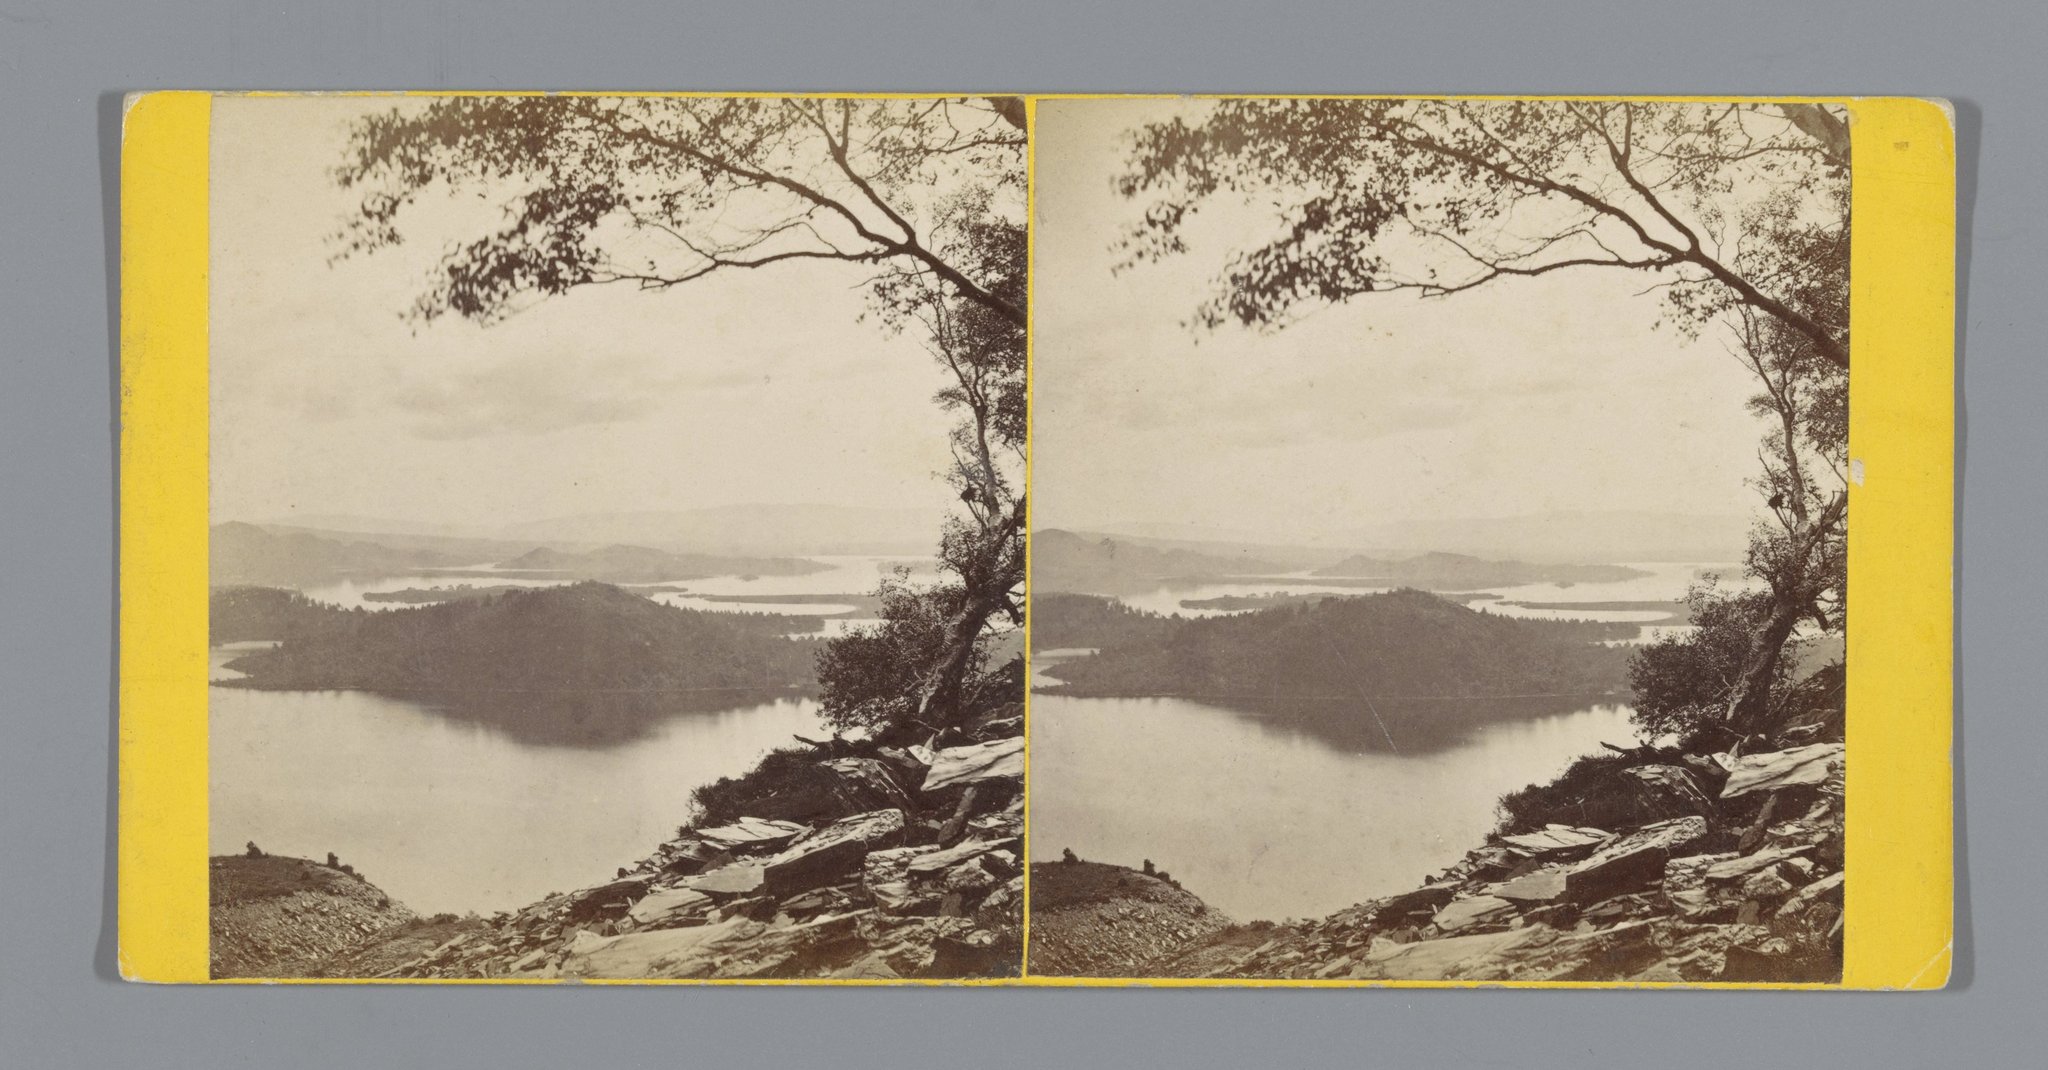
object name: stereograph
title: Loch Lomond-from Luss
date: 1858-1872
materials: cardboard, photographic support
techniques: albumen print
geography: loch lomond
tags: lake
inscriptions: number: ‘No. 830.’